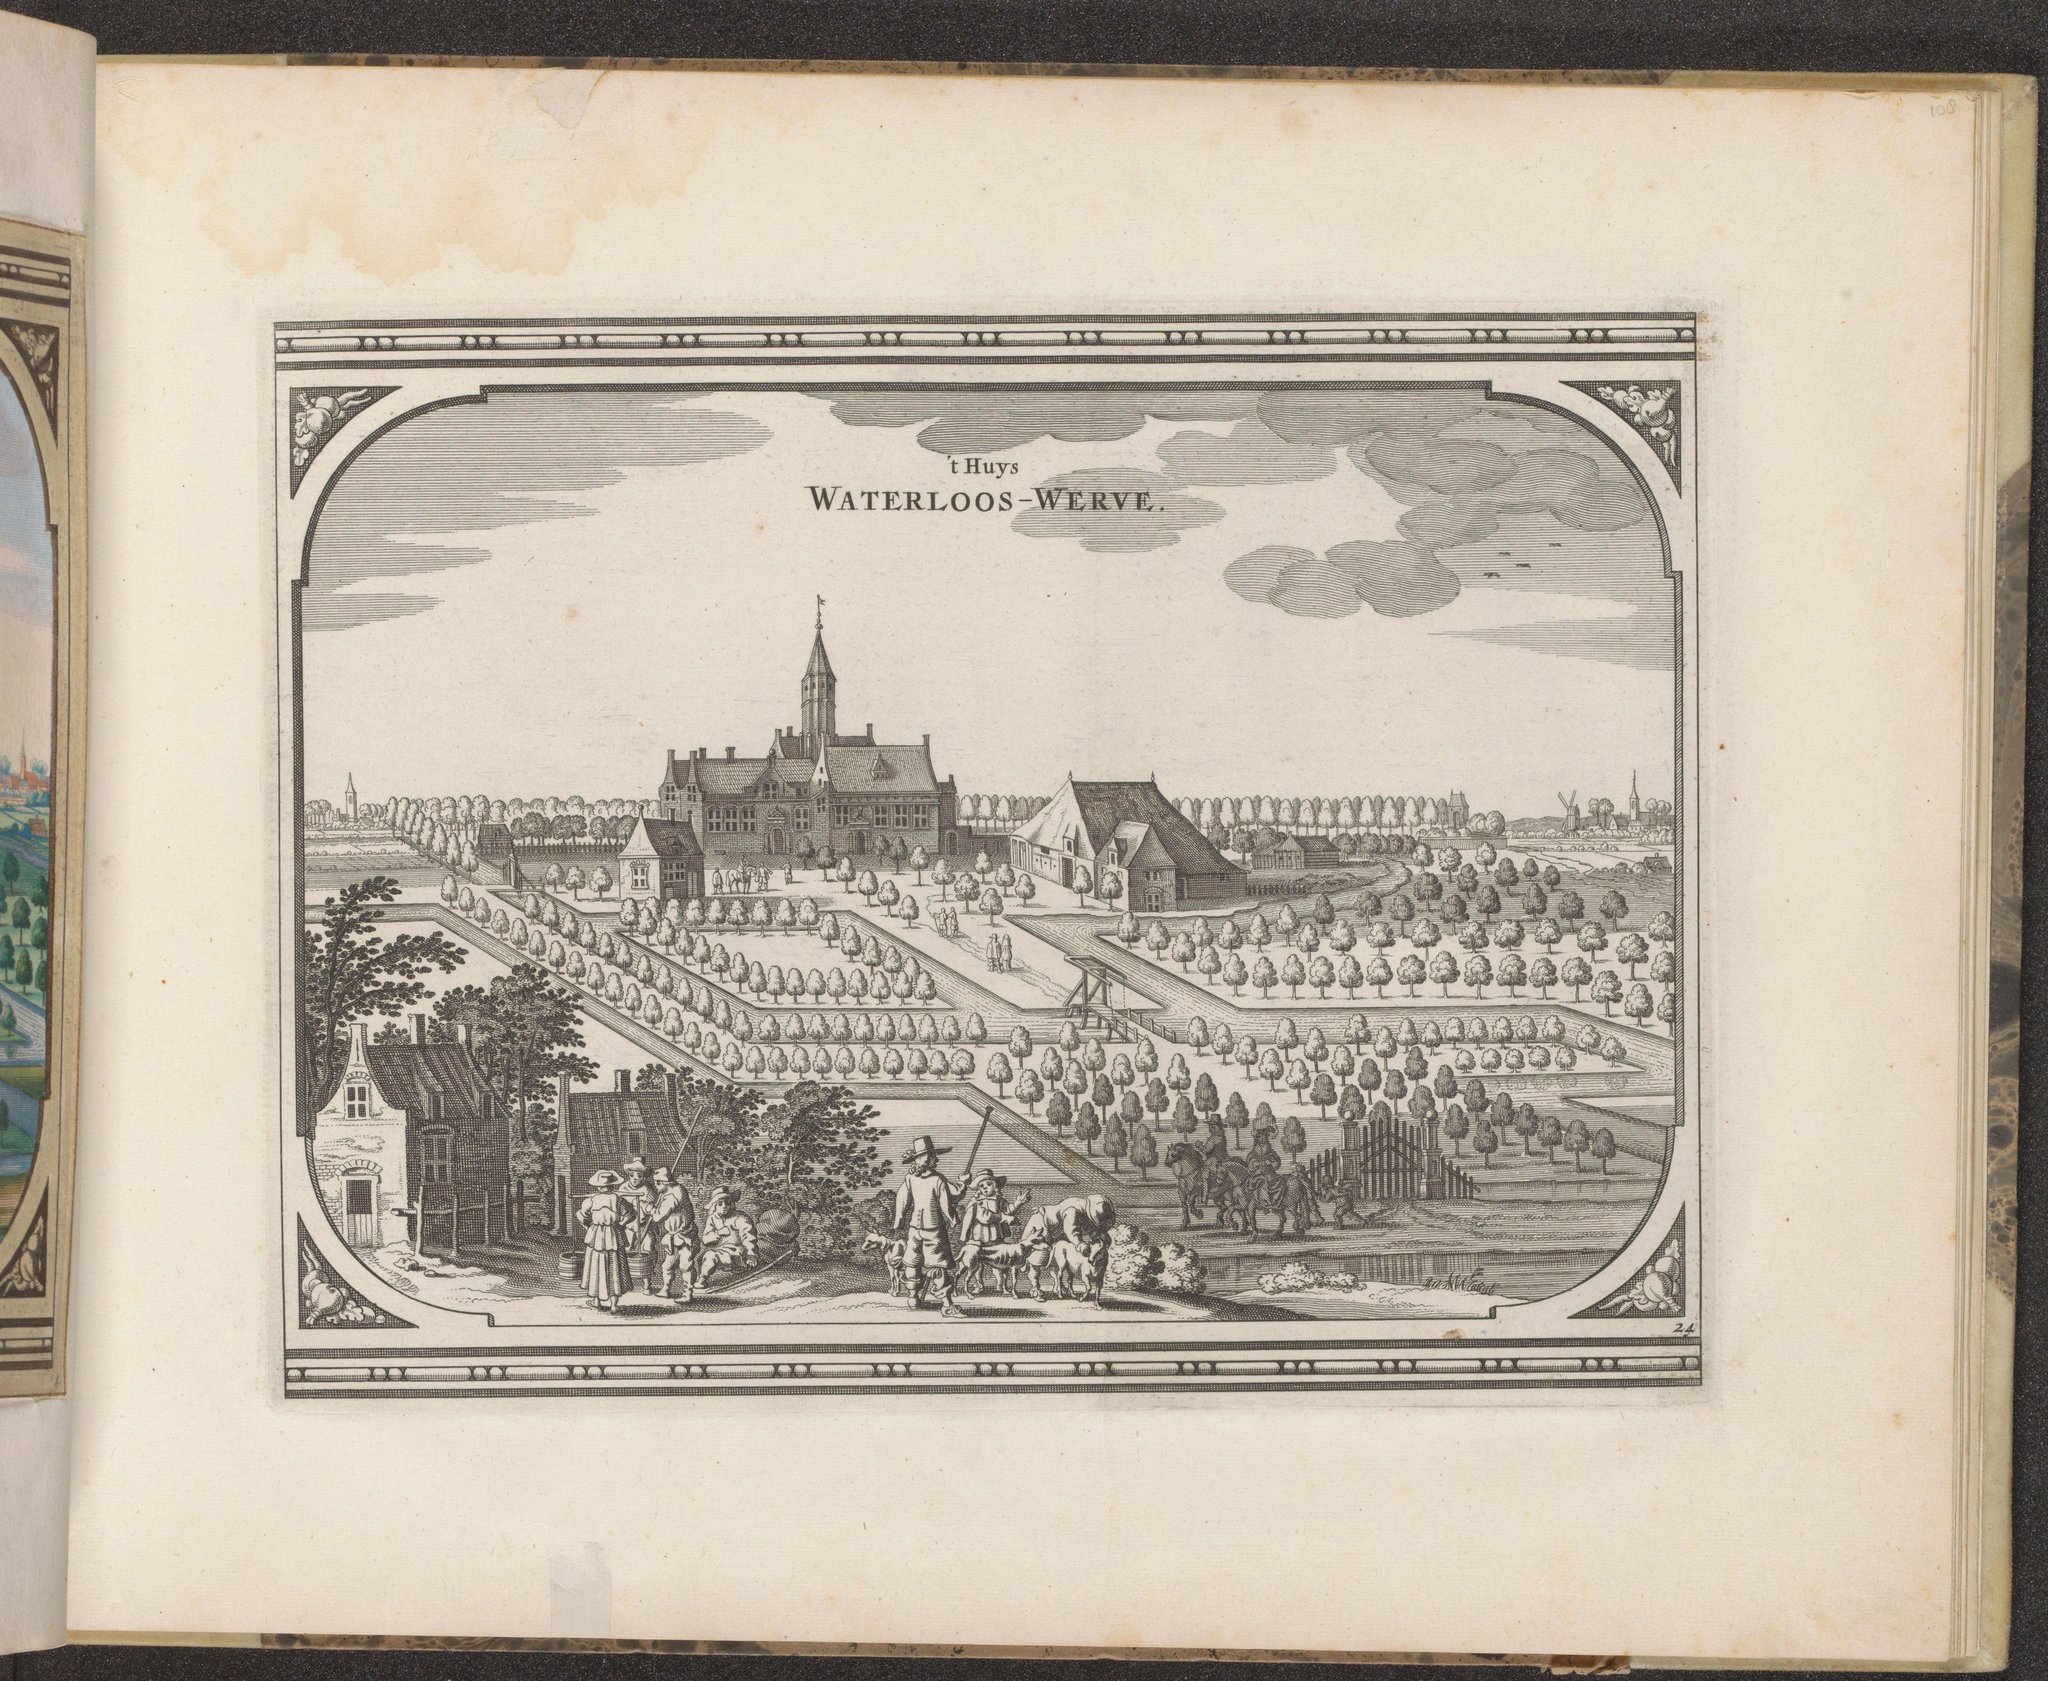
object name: print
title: Gezicht op Huis Waterlooswerve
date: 1662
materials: paper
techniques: etching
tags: city-view, and landscape with man-made constructions, garden, farmers, carrying something with yoke, bridge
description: Gezicht op Huis Waterlooswerve, een buitenplaats in Aagtekerke. Op de voorgrond links twee huisjes en boeren. Een vrouw draagt twee emmers aan een juk. Rechts daarvan drie welgestelde heren met hun honden. De prent maakt deel uit van een album.